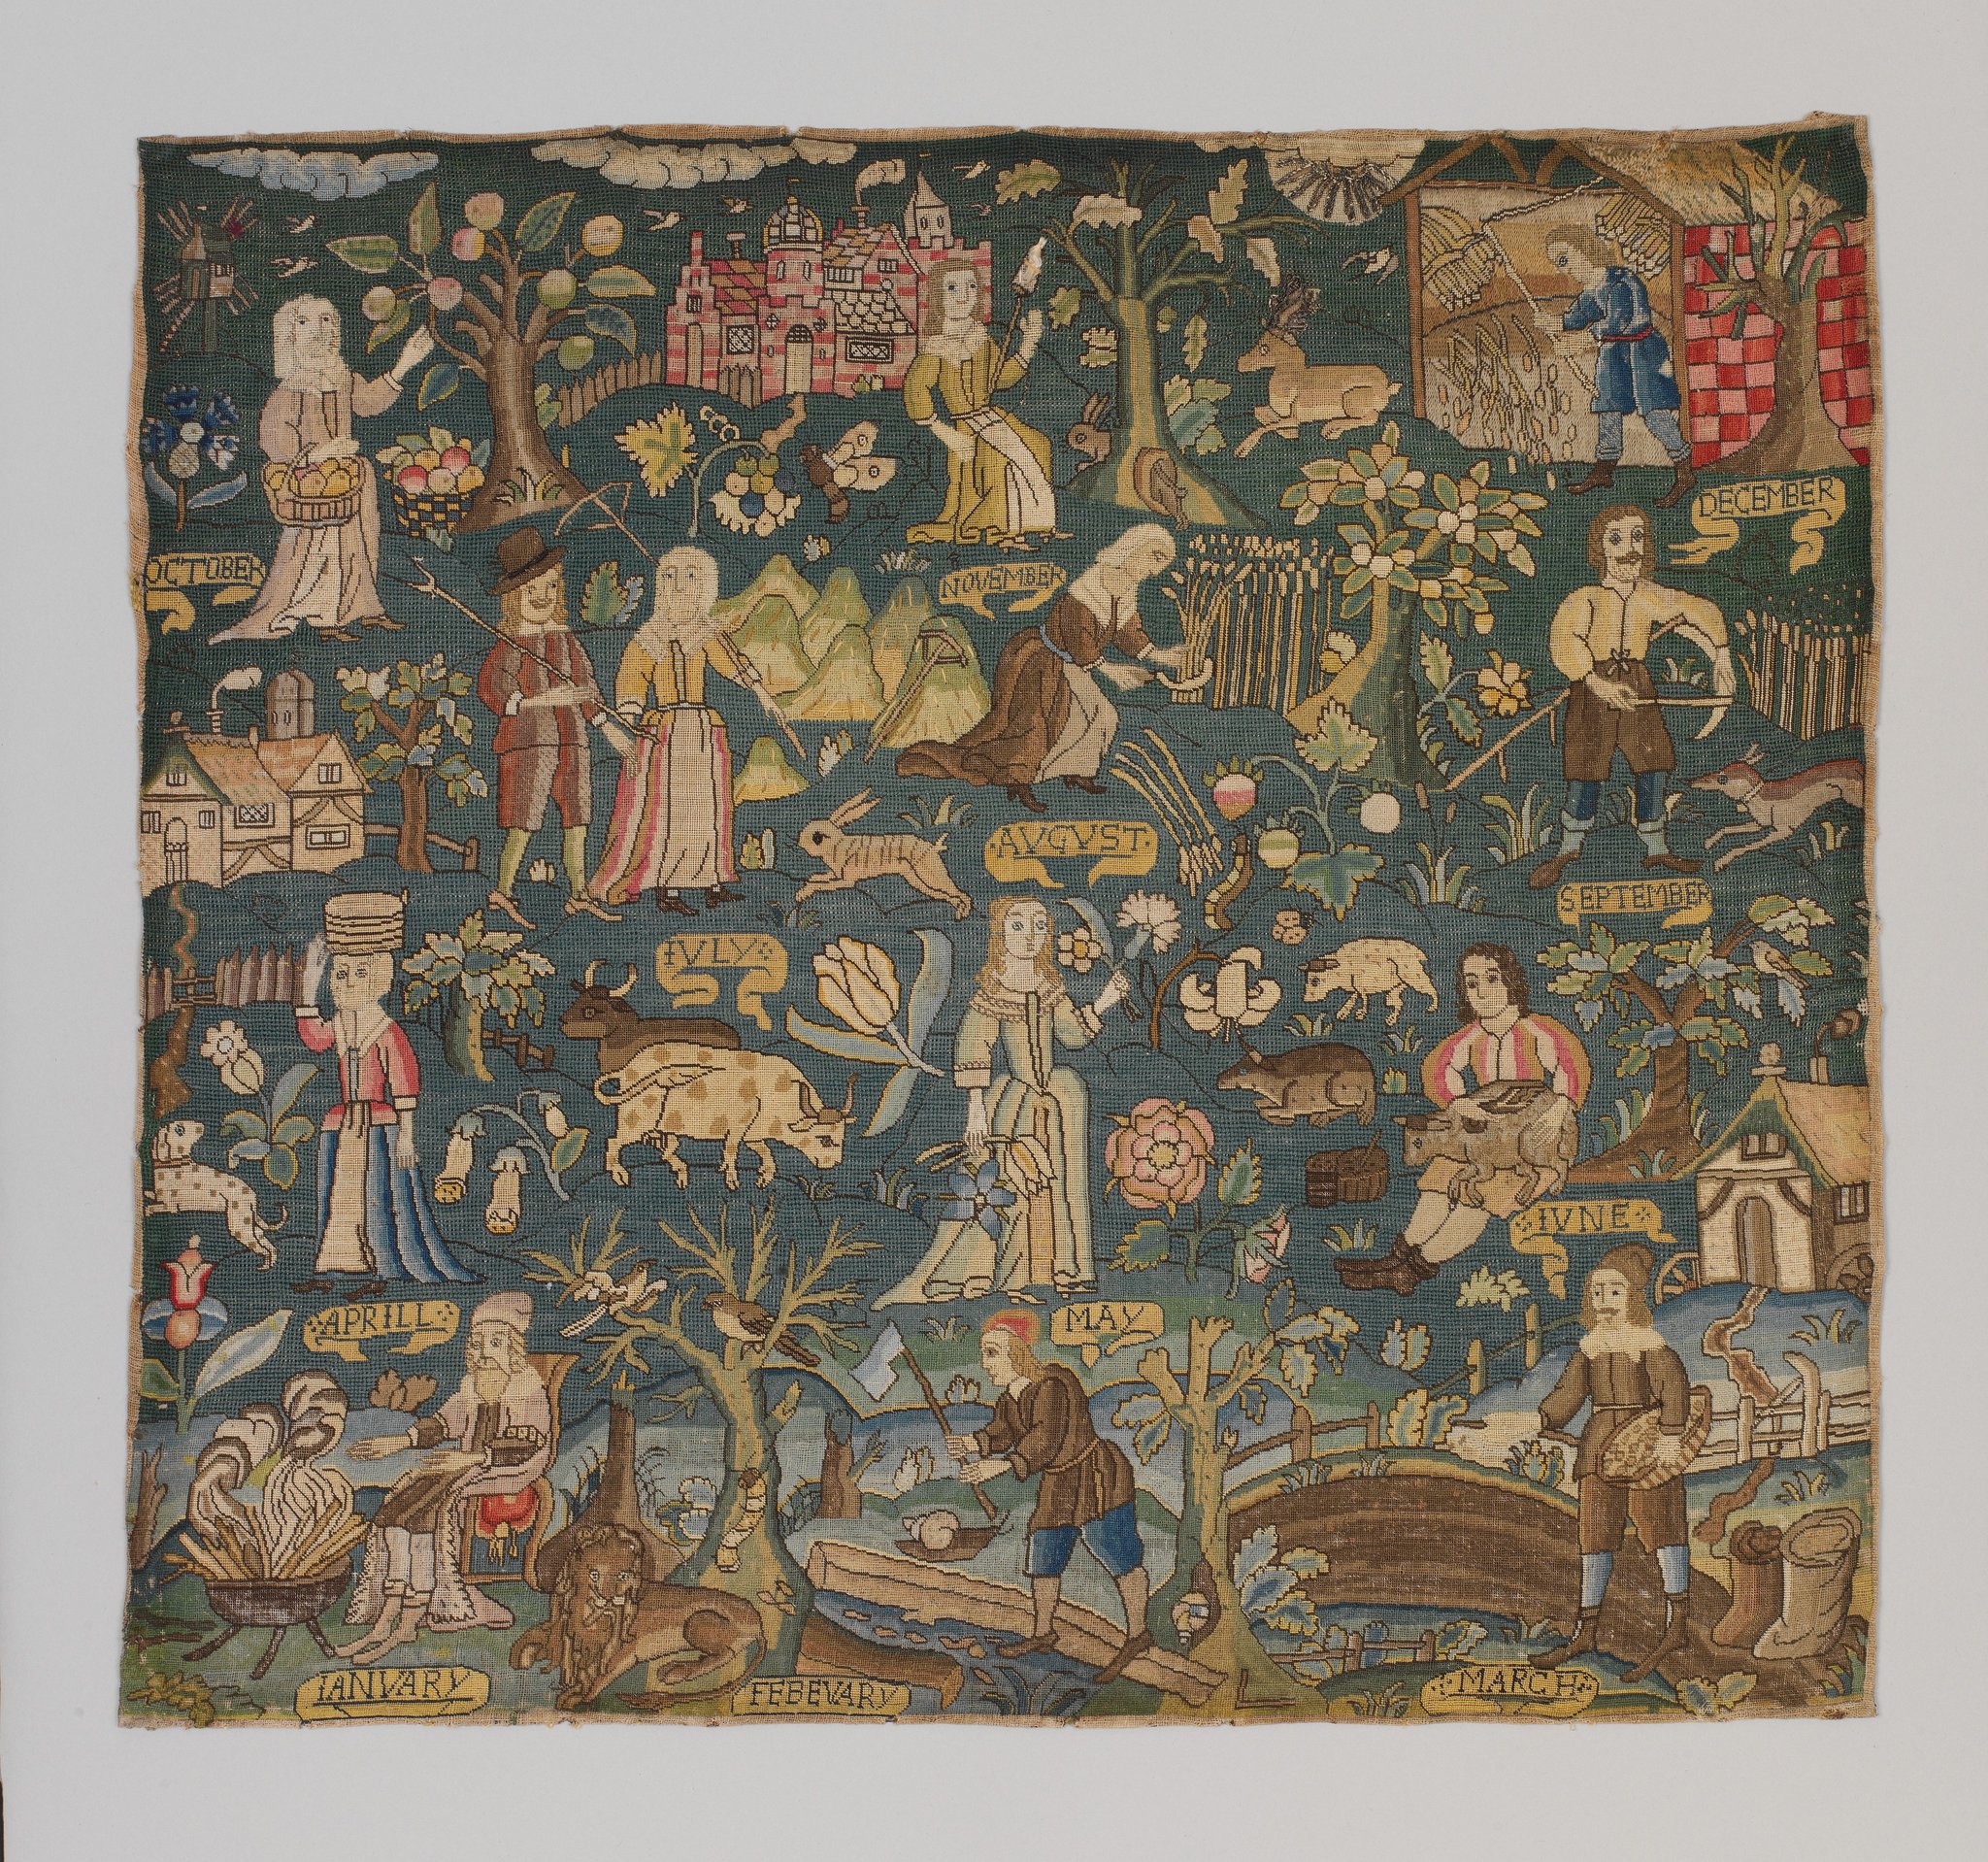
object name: embroidered picture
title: Labors of the Months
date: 1626-1650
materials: canvas, metal thread, silk, wool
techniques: embroidery, stitching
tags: birds,men,women,cows,deer,lions,rabbits